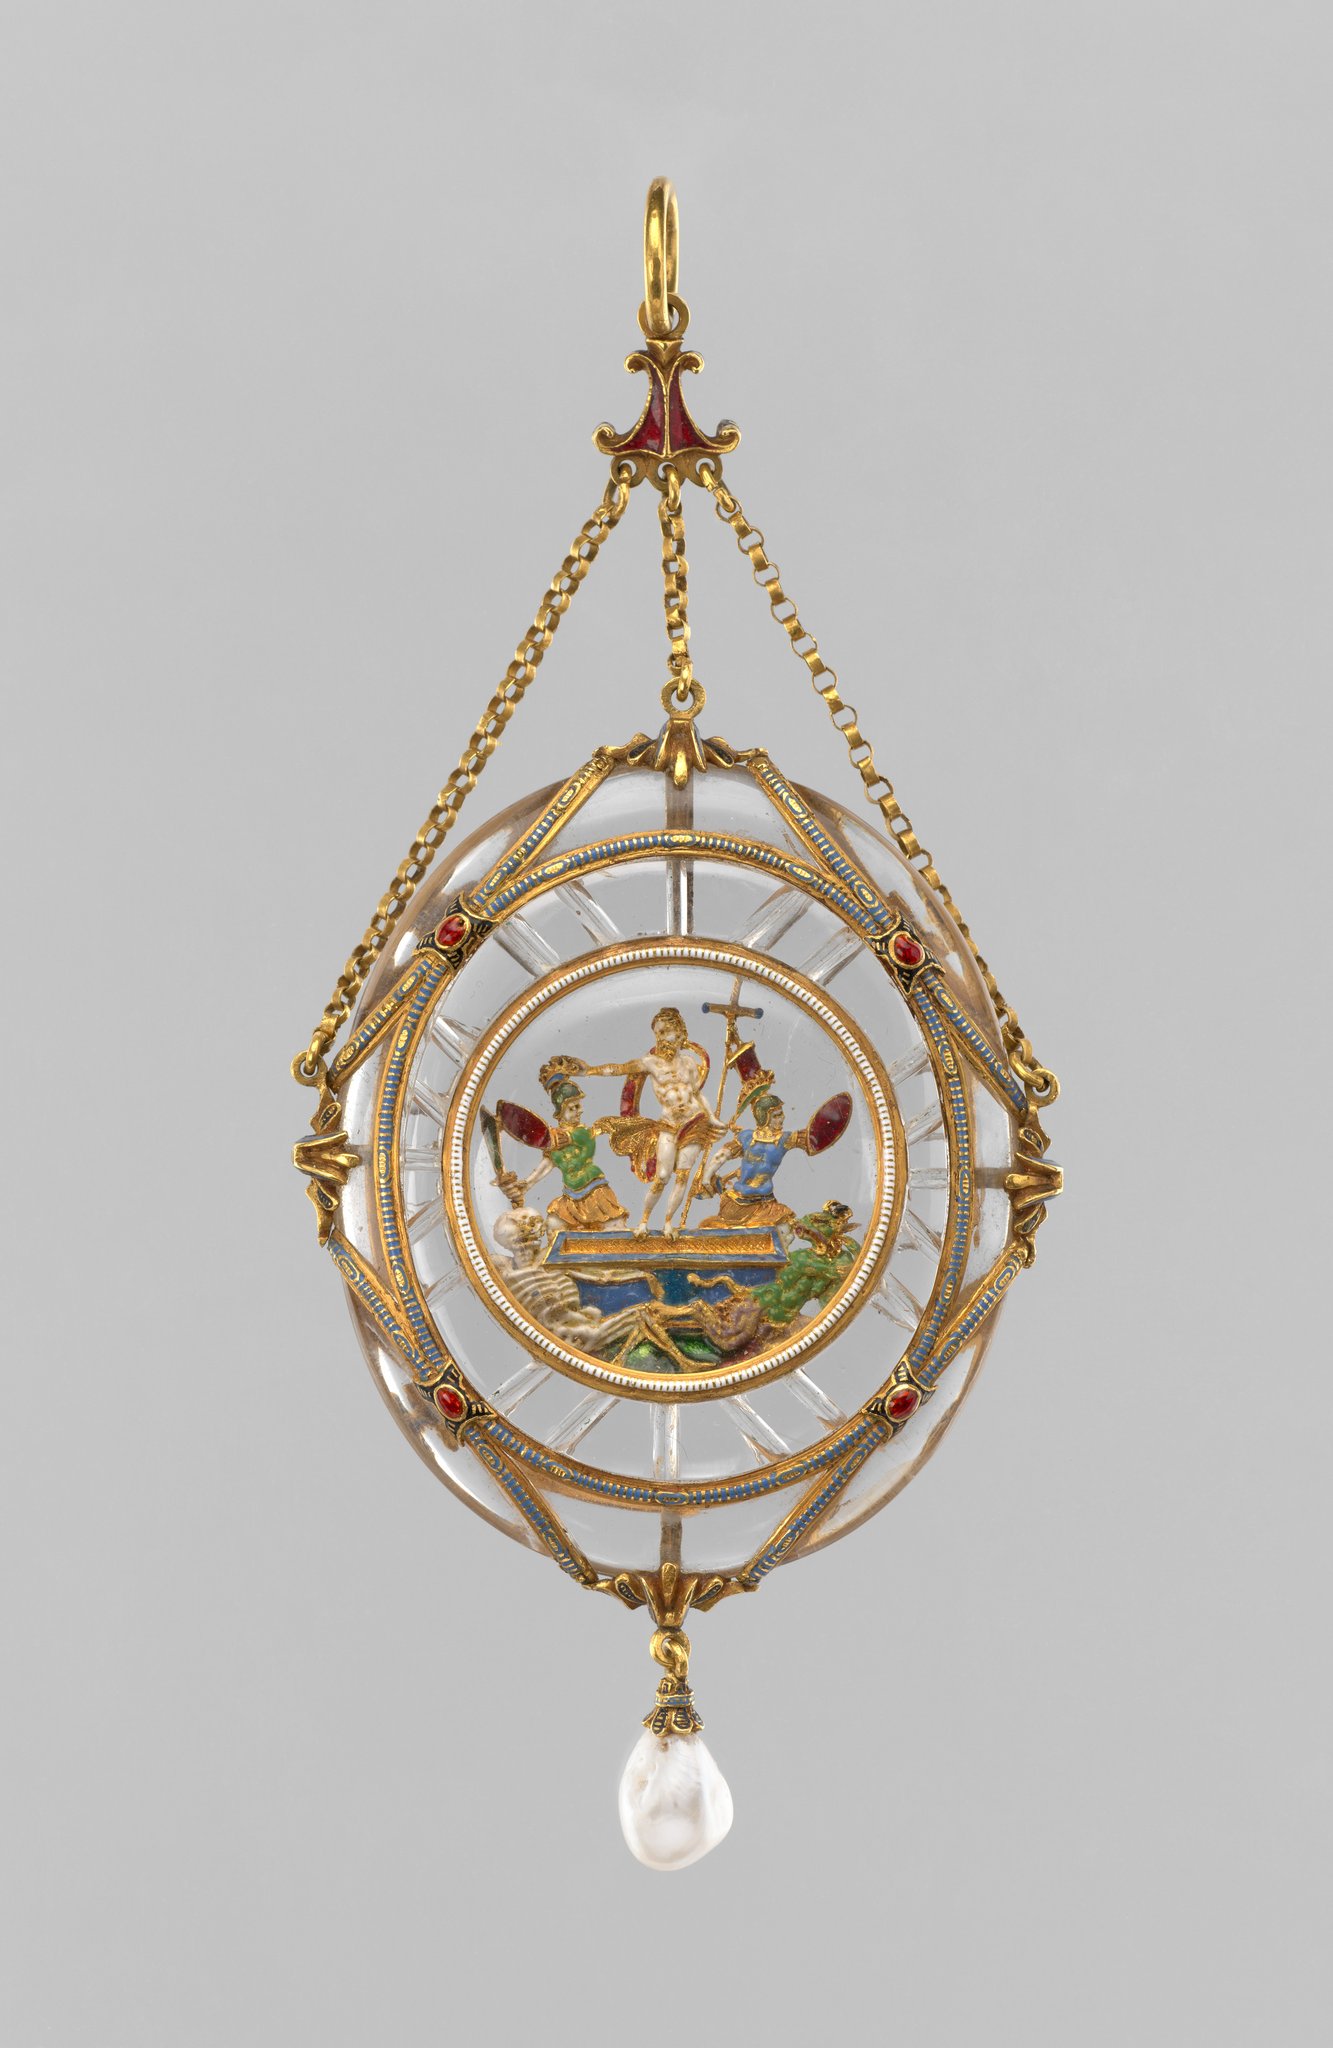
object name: pendant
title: The Resurrection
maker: alfred andré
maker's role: maker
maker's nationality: french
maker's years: 1839-1919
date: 1801-1900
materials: enamel, gold, pearl, quartz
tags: men,cross,jesus